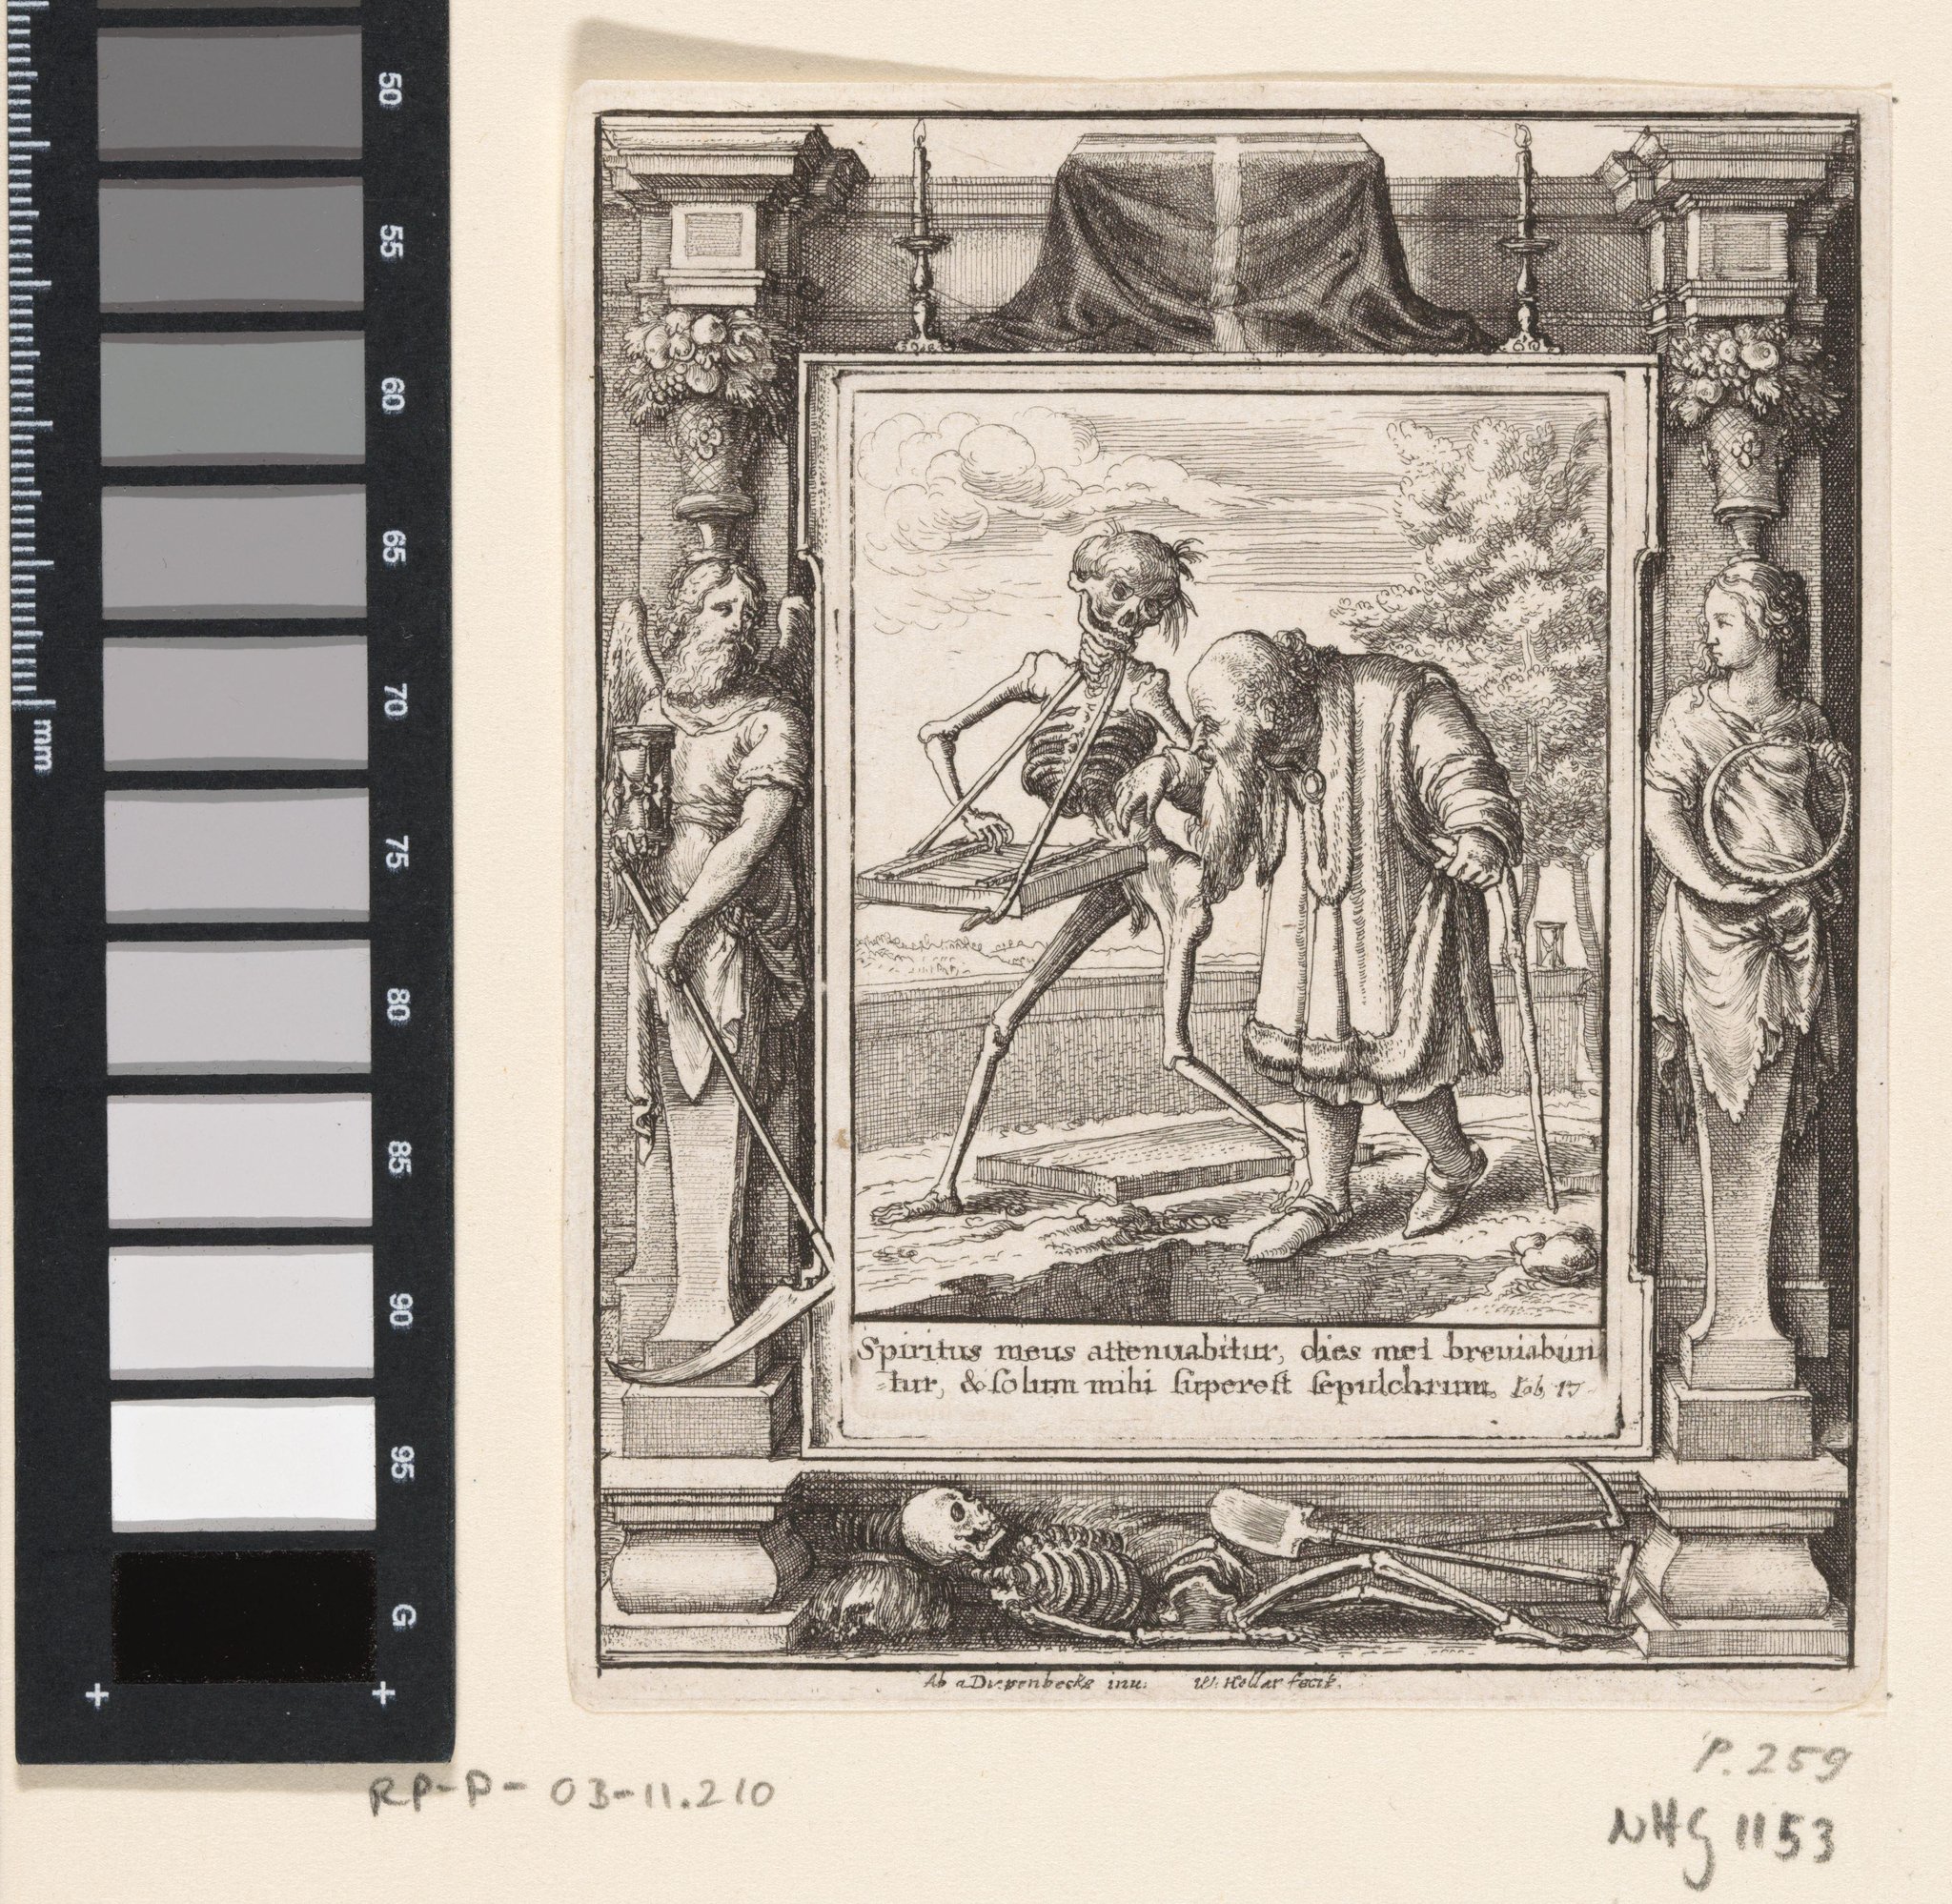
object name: print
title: Dodendans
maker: wenceslaus hollar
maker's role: draughtsman, print maker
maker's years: 1607-1677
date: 1651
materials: paper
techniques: etching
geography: antwerp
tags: dance of death; death together with one or more human beings, eternity, 'aeternitas'; 'eternità','eternità o perpetuità' (ripa), old man, father time, man with wings and scythe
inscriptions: collector's mark: Lugt 2228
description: De Dood leidt een oude man naar zijn graf. 28ste prent uit een reeks van 30 dodendansprenten; met een omlijsting met Tijd en Eeuwigheid.